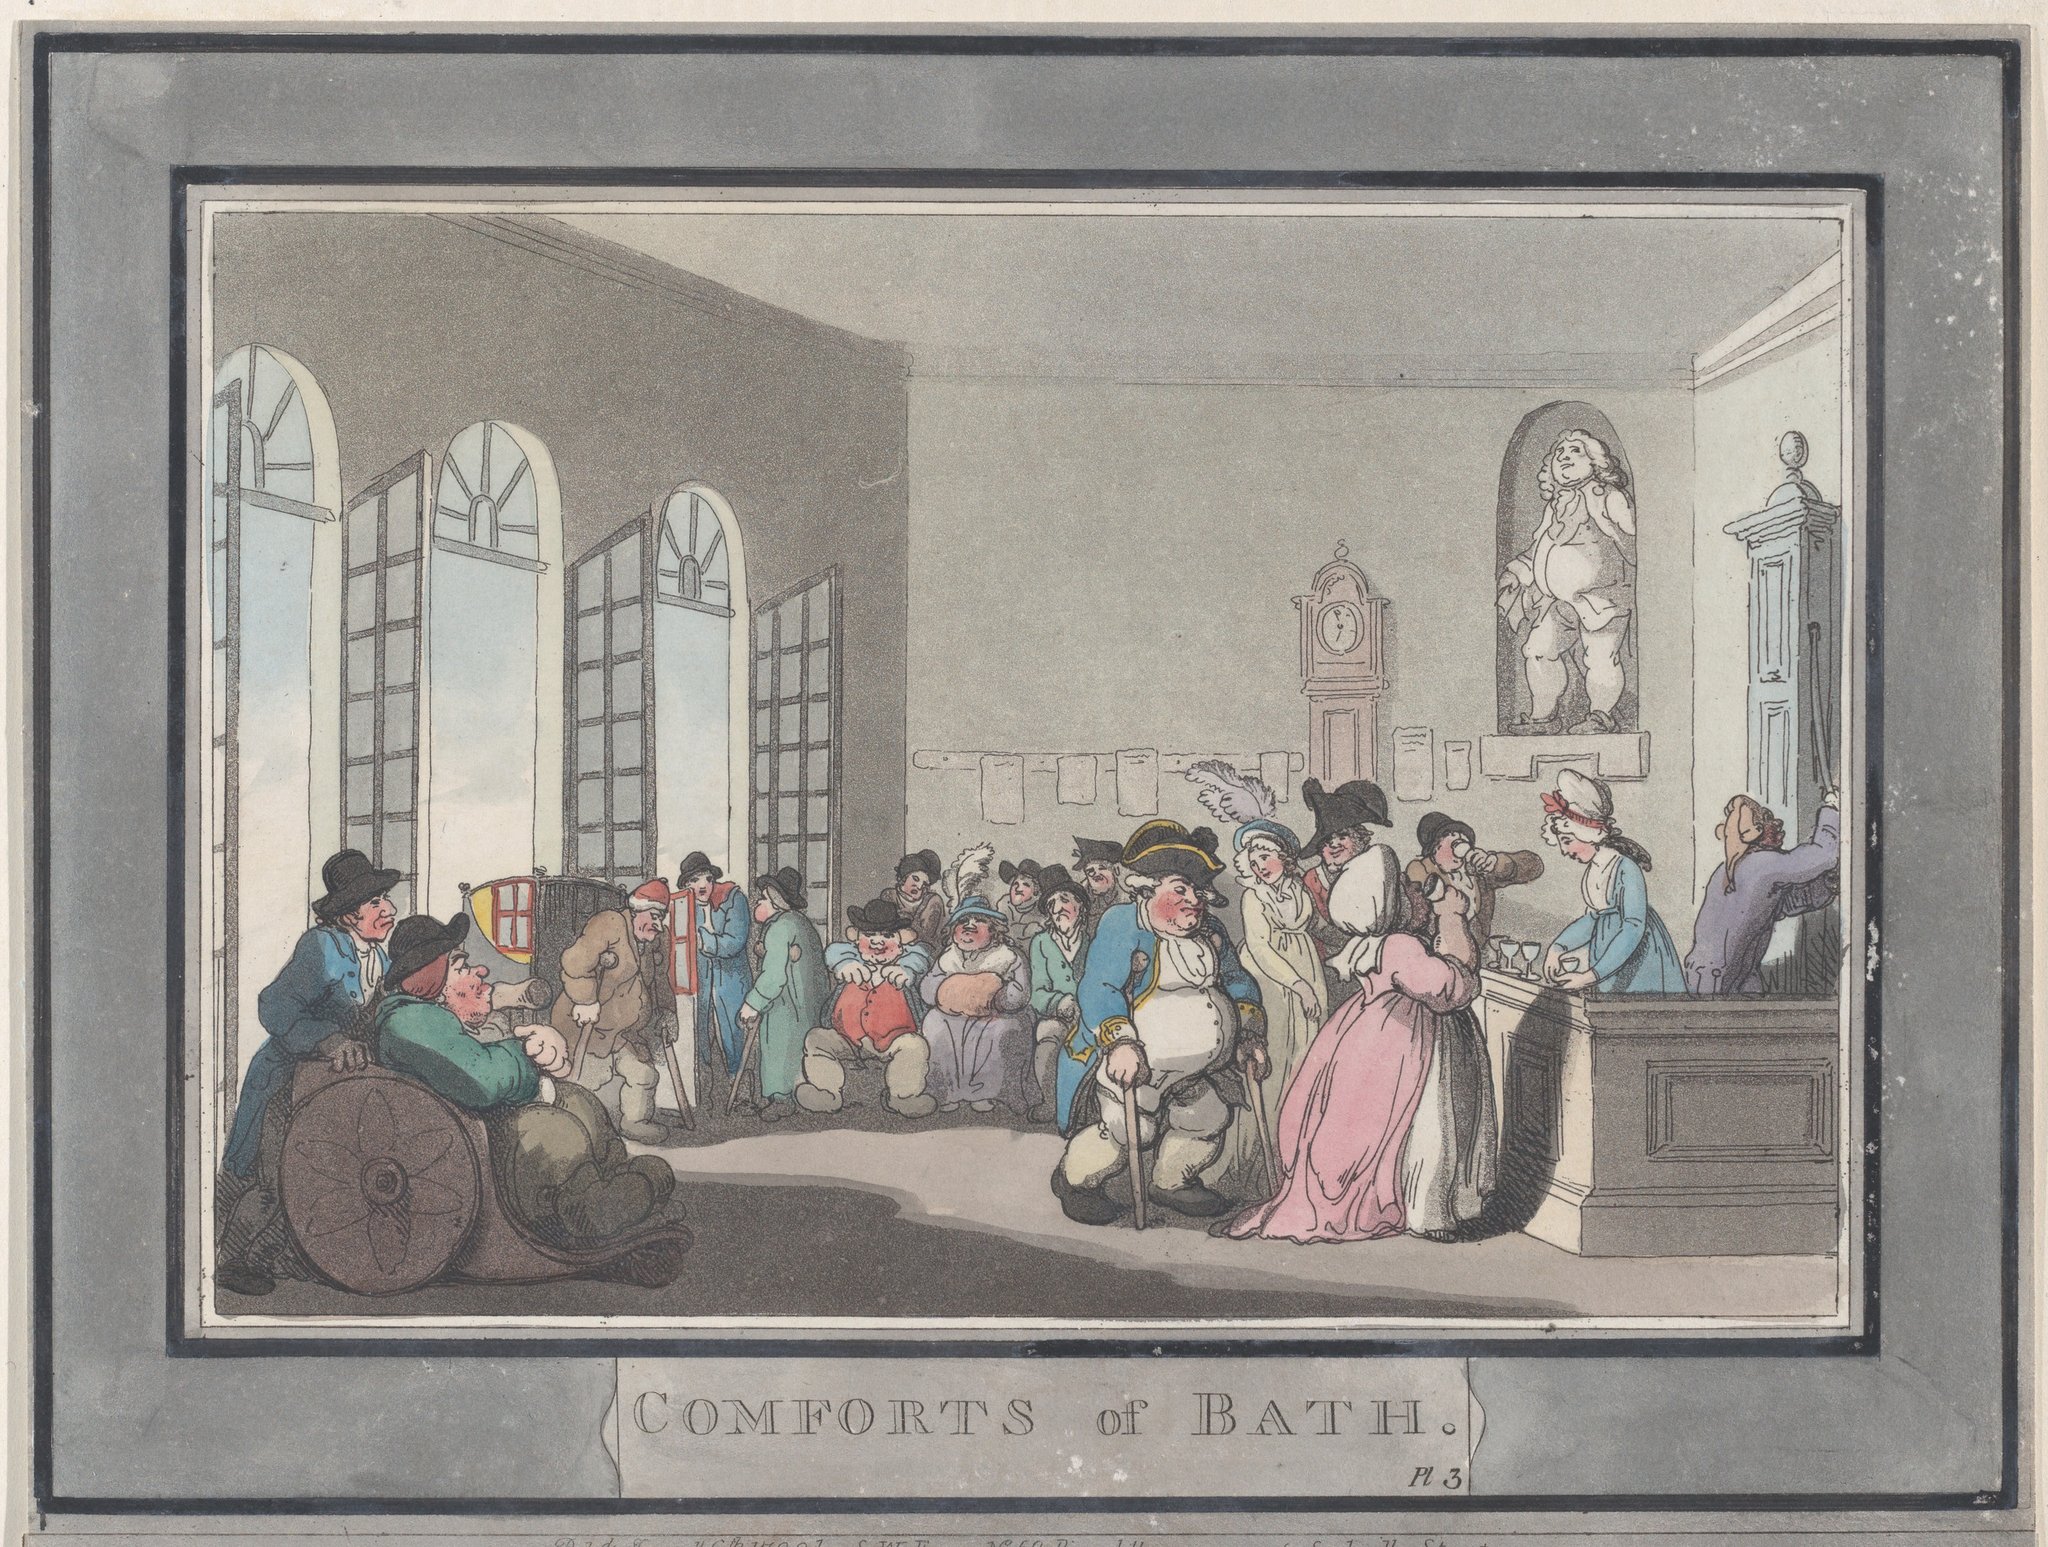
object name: print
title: Comforts of Bath, Plate 3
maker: thomas rowlandson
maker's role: artist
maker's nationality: british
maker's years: 1757-1827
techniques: aquatint, etching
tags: satire,men,women,drinking